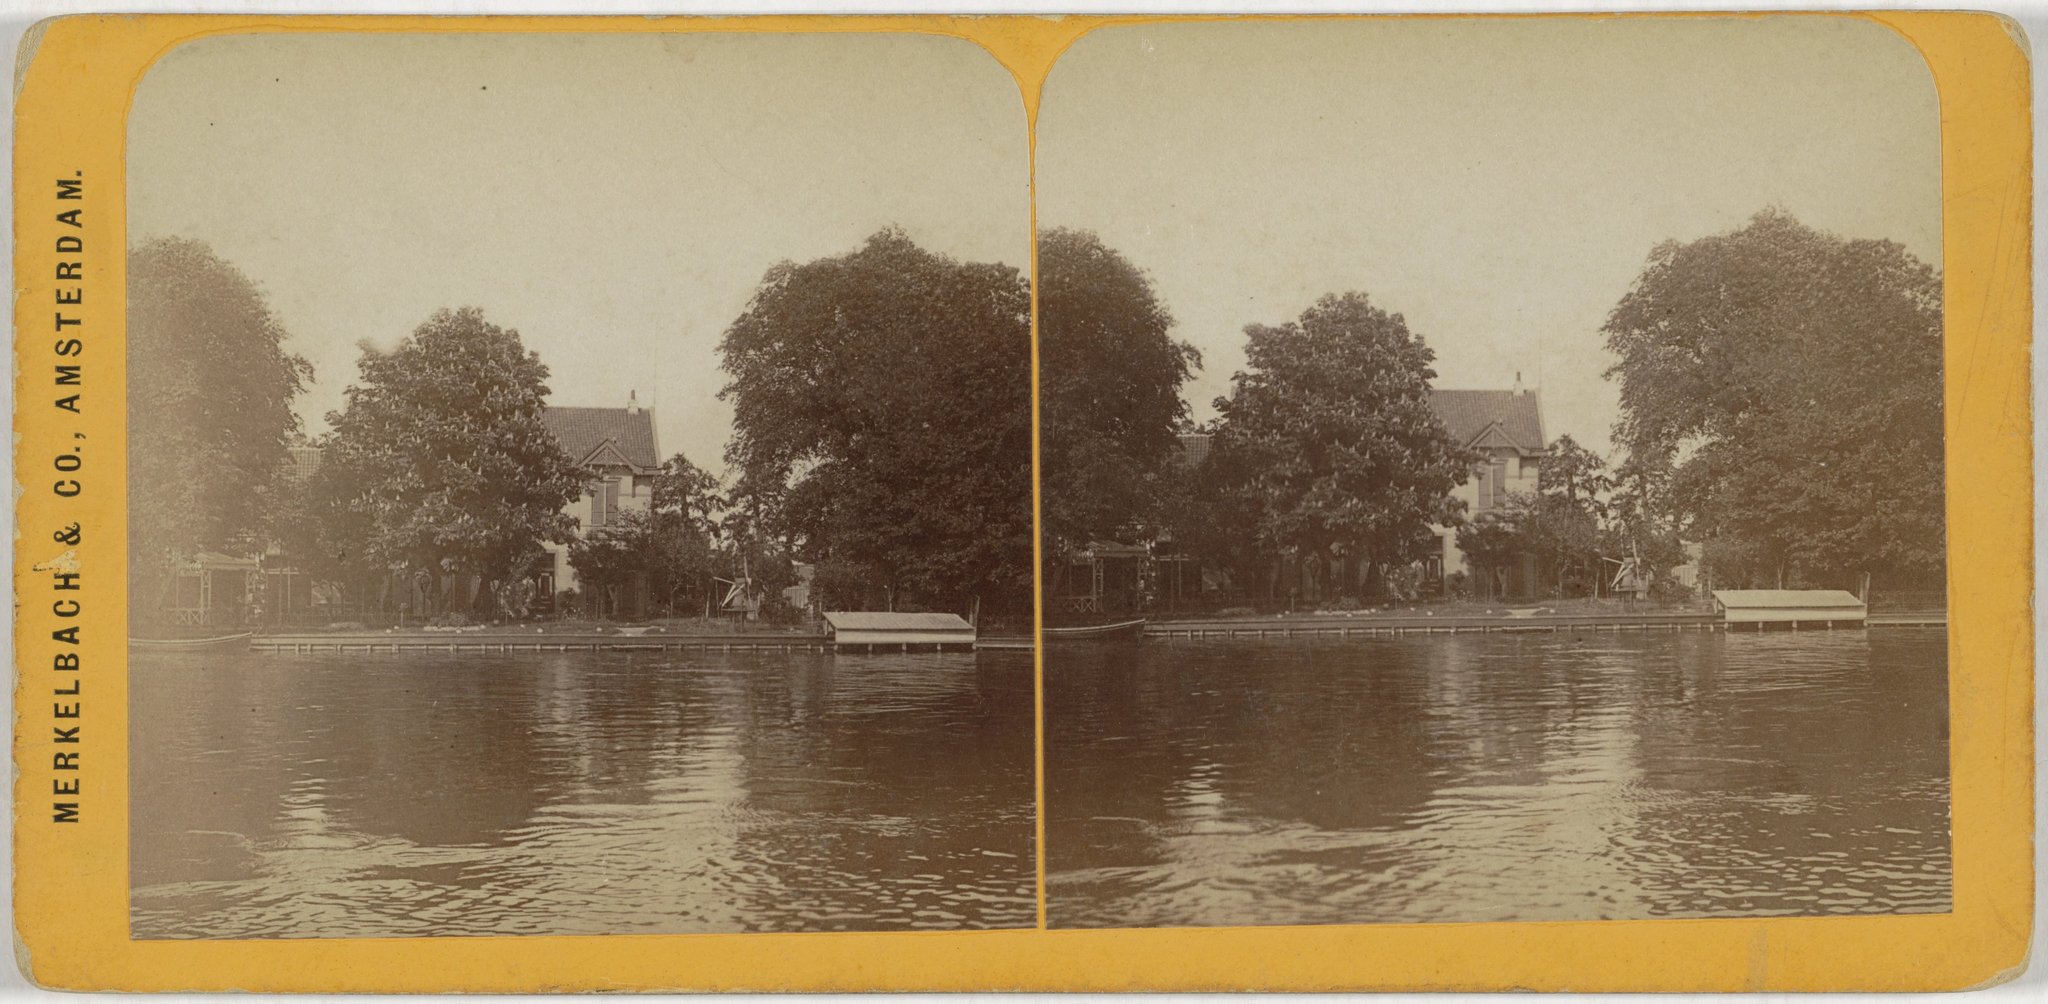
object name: stereograph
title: Gezicht op de Amstel bij Ouderkerk aan de Amstel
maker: Anonymous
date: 1873-1890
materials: cardboard, paper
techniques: albumen print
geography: ouderkerk aan de amstel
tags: river bank, villa